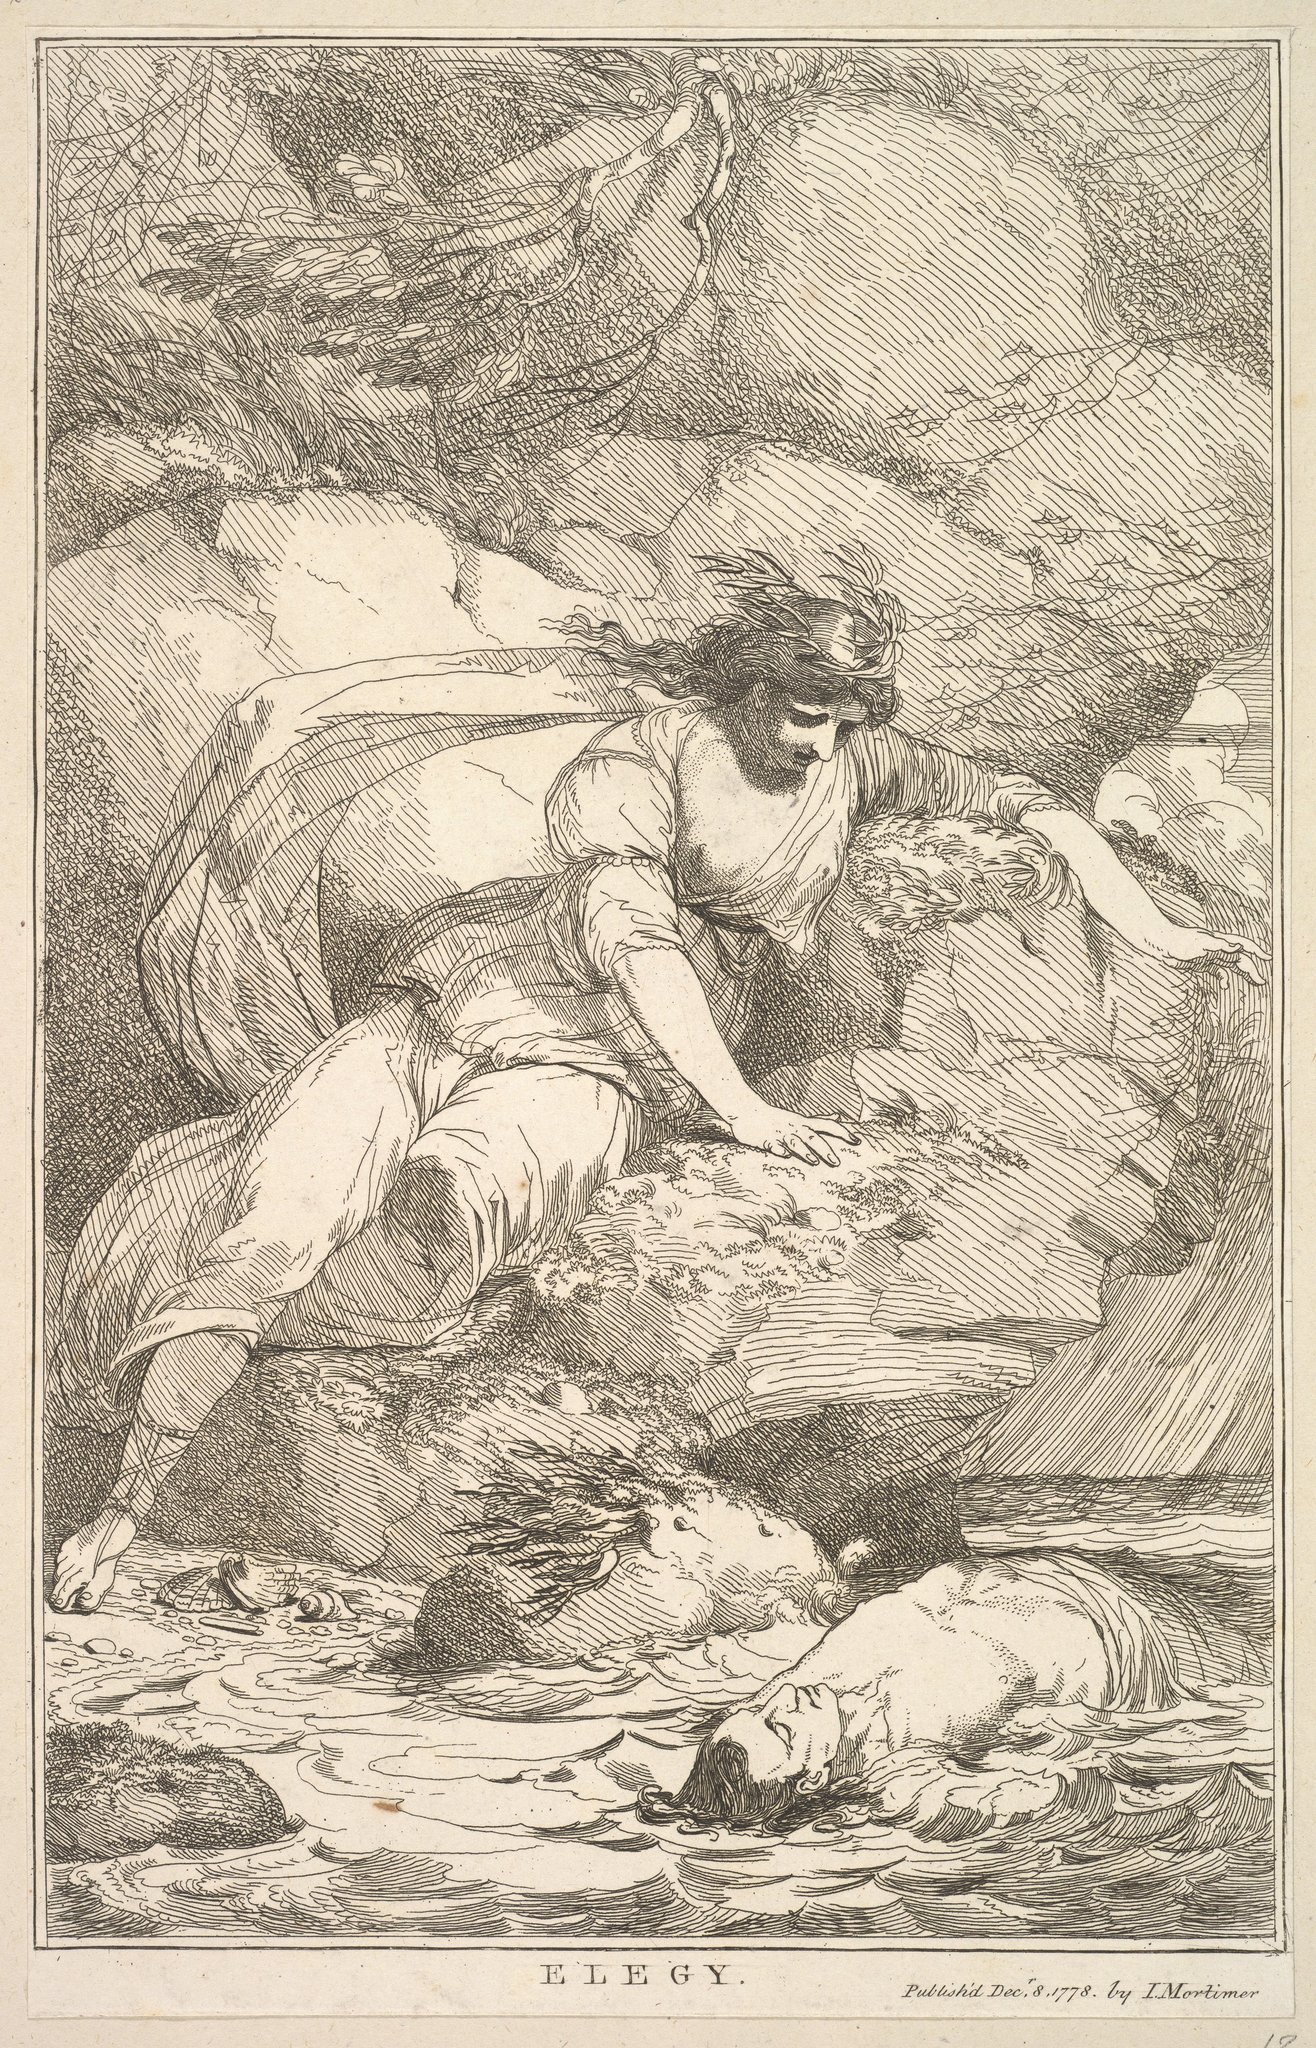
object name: print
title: Elegy, from "Fifteen Etchings Dedicated to Sir Joshua Reynolds"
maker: john hamilton mortimer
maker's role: artist and publisher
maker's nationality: british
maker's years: 1740-1779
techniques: etching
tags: men,women,death